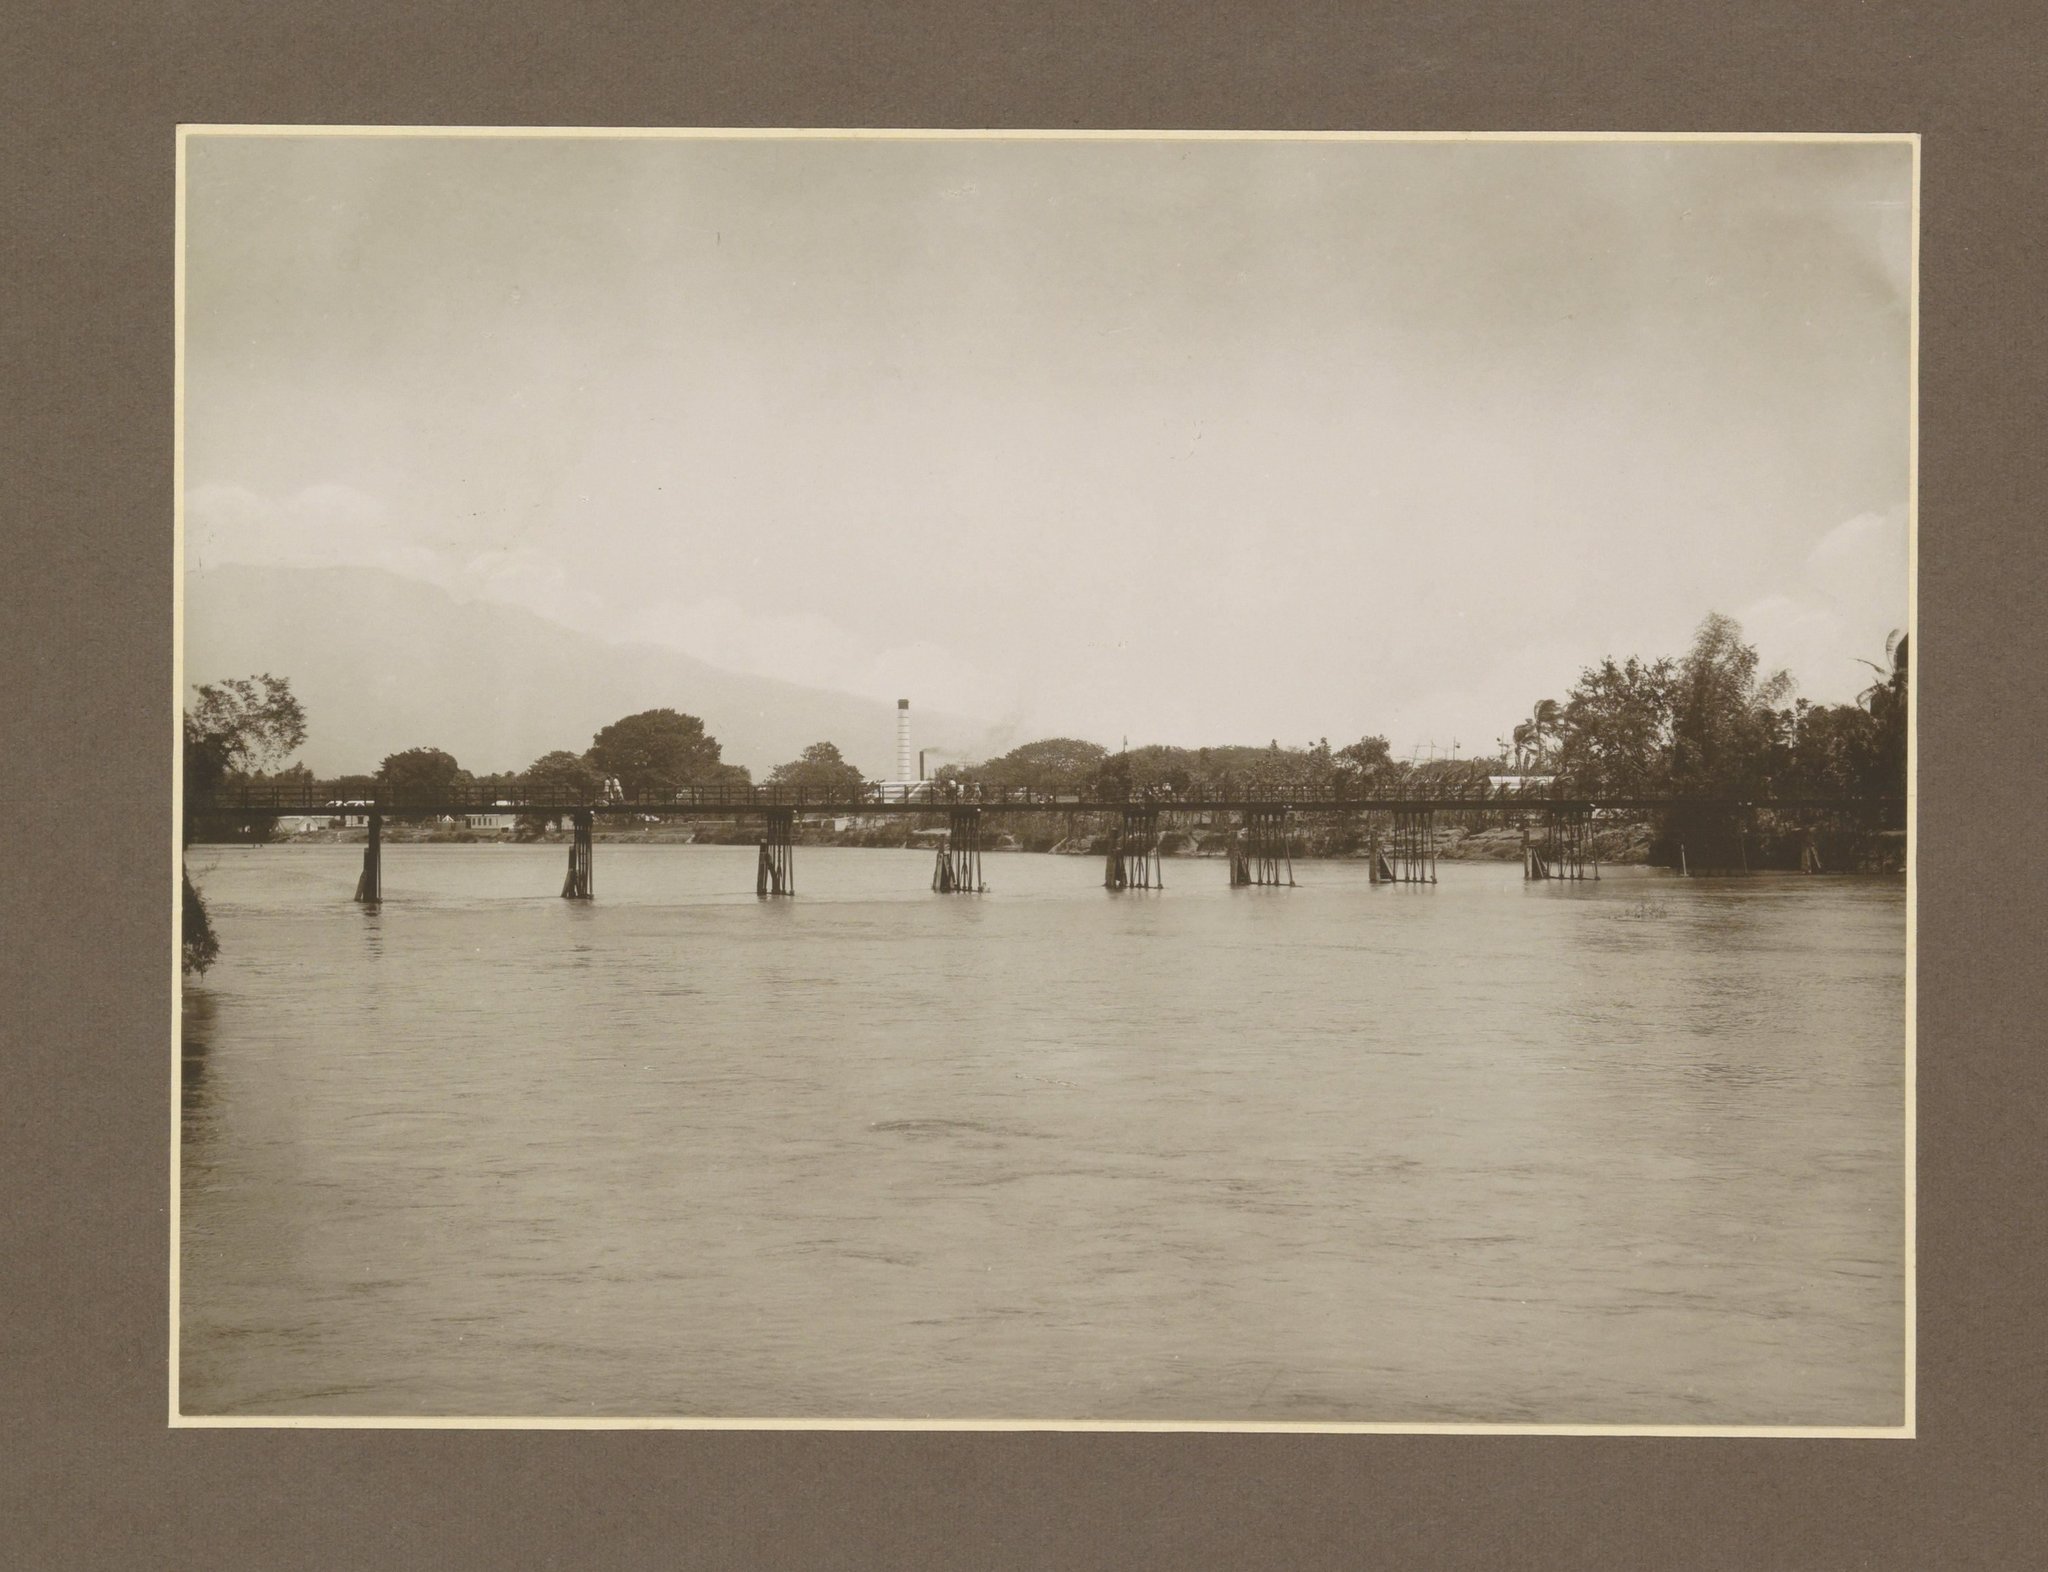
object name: photograph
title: Sf. Meritjan Brantasbrug voor riettransport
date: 1925-1930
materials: cardboard, paper, photographic support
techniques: gelatin silver print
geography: kediri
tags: plantation, landscape with bridge, viaduct or aqueduct, bridge in village across river, canal, etc., plants and herbs: sugarcane, sugar, dutch east indies, the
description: Onderdeel van Fotoalbum met opnames van vier suikerfabrieken op Java.